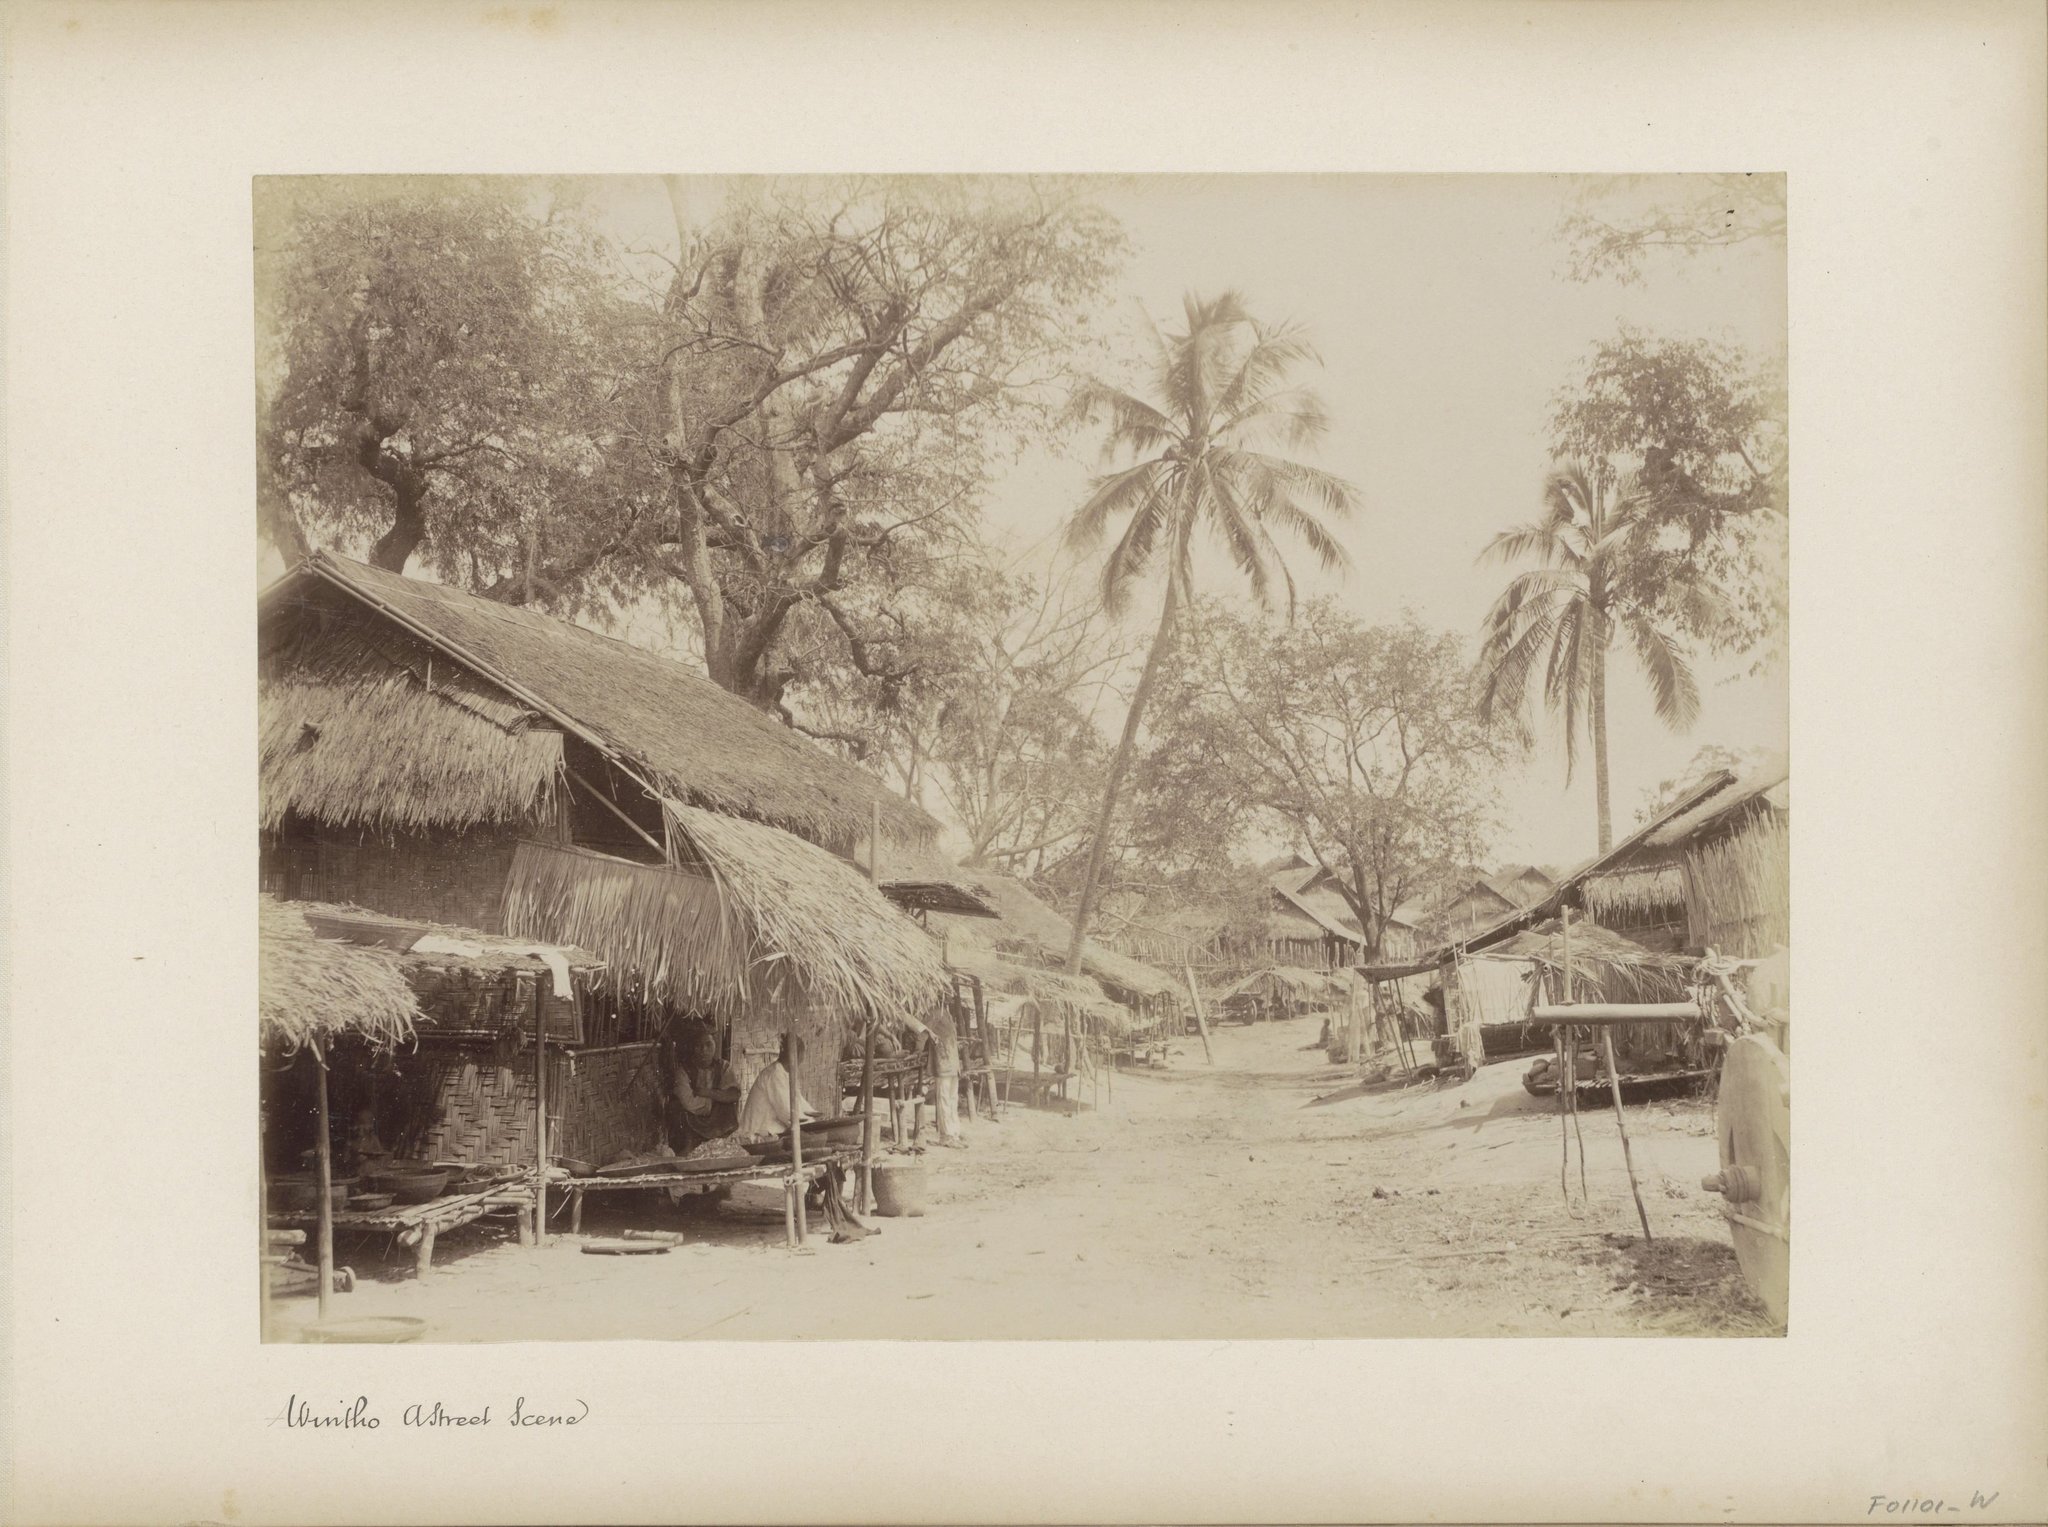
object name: photograph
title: Street with rows of houses in Wuntho, Sagaing, Myanmar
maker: Anonymous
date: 1885-1886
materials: cardboard, paper, photographic support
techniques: albumen print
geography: myanmar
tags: street (+ city(-scape) with figures, staffage)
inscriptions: caption: ‘Wintho A Street Scene’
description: Onderdeel van Reisalbum met foto's van bezienswaardigheden in Birma.